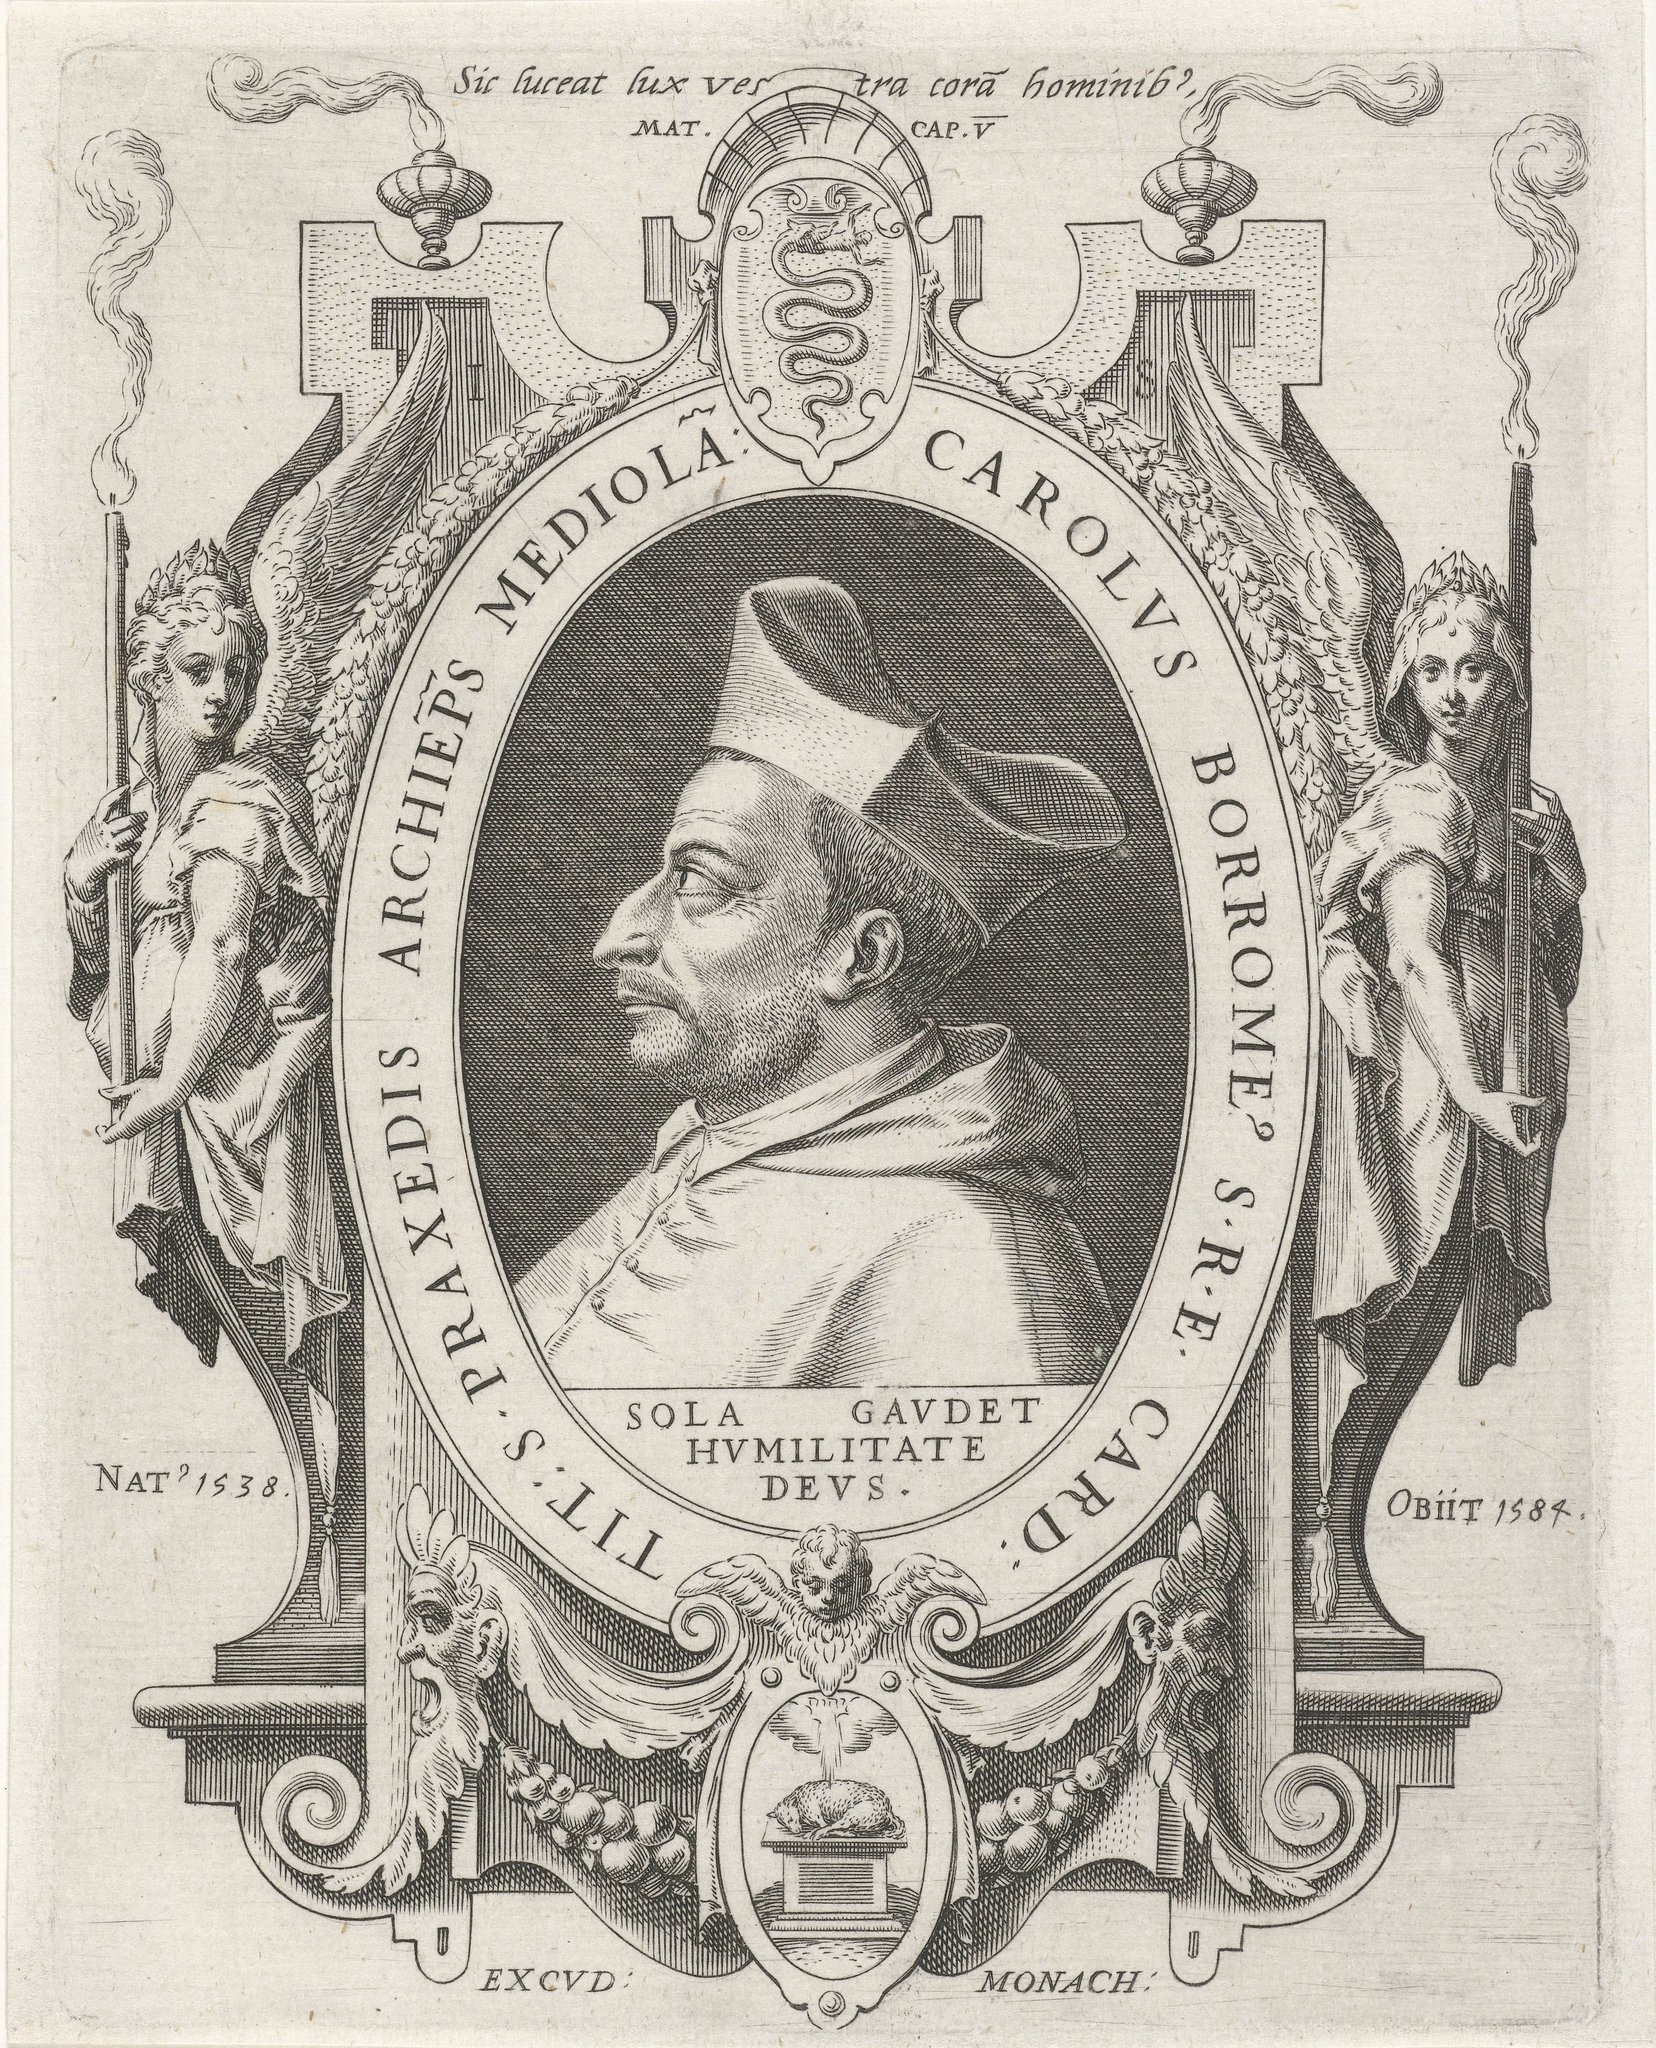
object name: print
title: Portret van Carolus Borromeüs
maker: johann sadeler (i)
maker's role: print maker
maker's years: 1550-1600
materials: paper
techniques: engraving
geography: munich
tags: snakes, archbishop, bishop, etc. (roman catholic), charles borromeo, cardinal of milan; possible attributes: cardinal's hat, crucifix, rope round his neck, skull, the vision of the lamb and the book with the seven seals, angels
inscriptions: collector's mark: Lugt 240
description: Portret in een ovale lijst van Carolus Borromeus. Hij draagt de biretta. De lijst is aan weerszijden versierd met een engel die een kaars draagt. Onder het portret een afbeelding van het Lam Gods. Boven het portret een afbeelding van een slang die een mens verslindt.